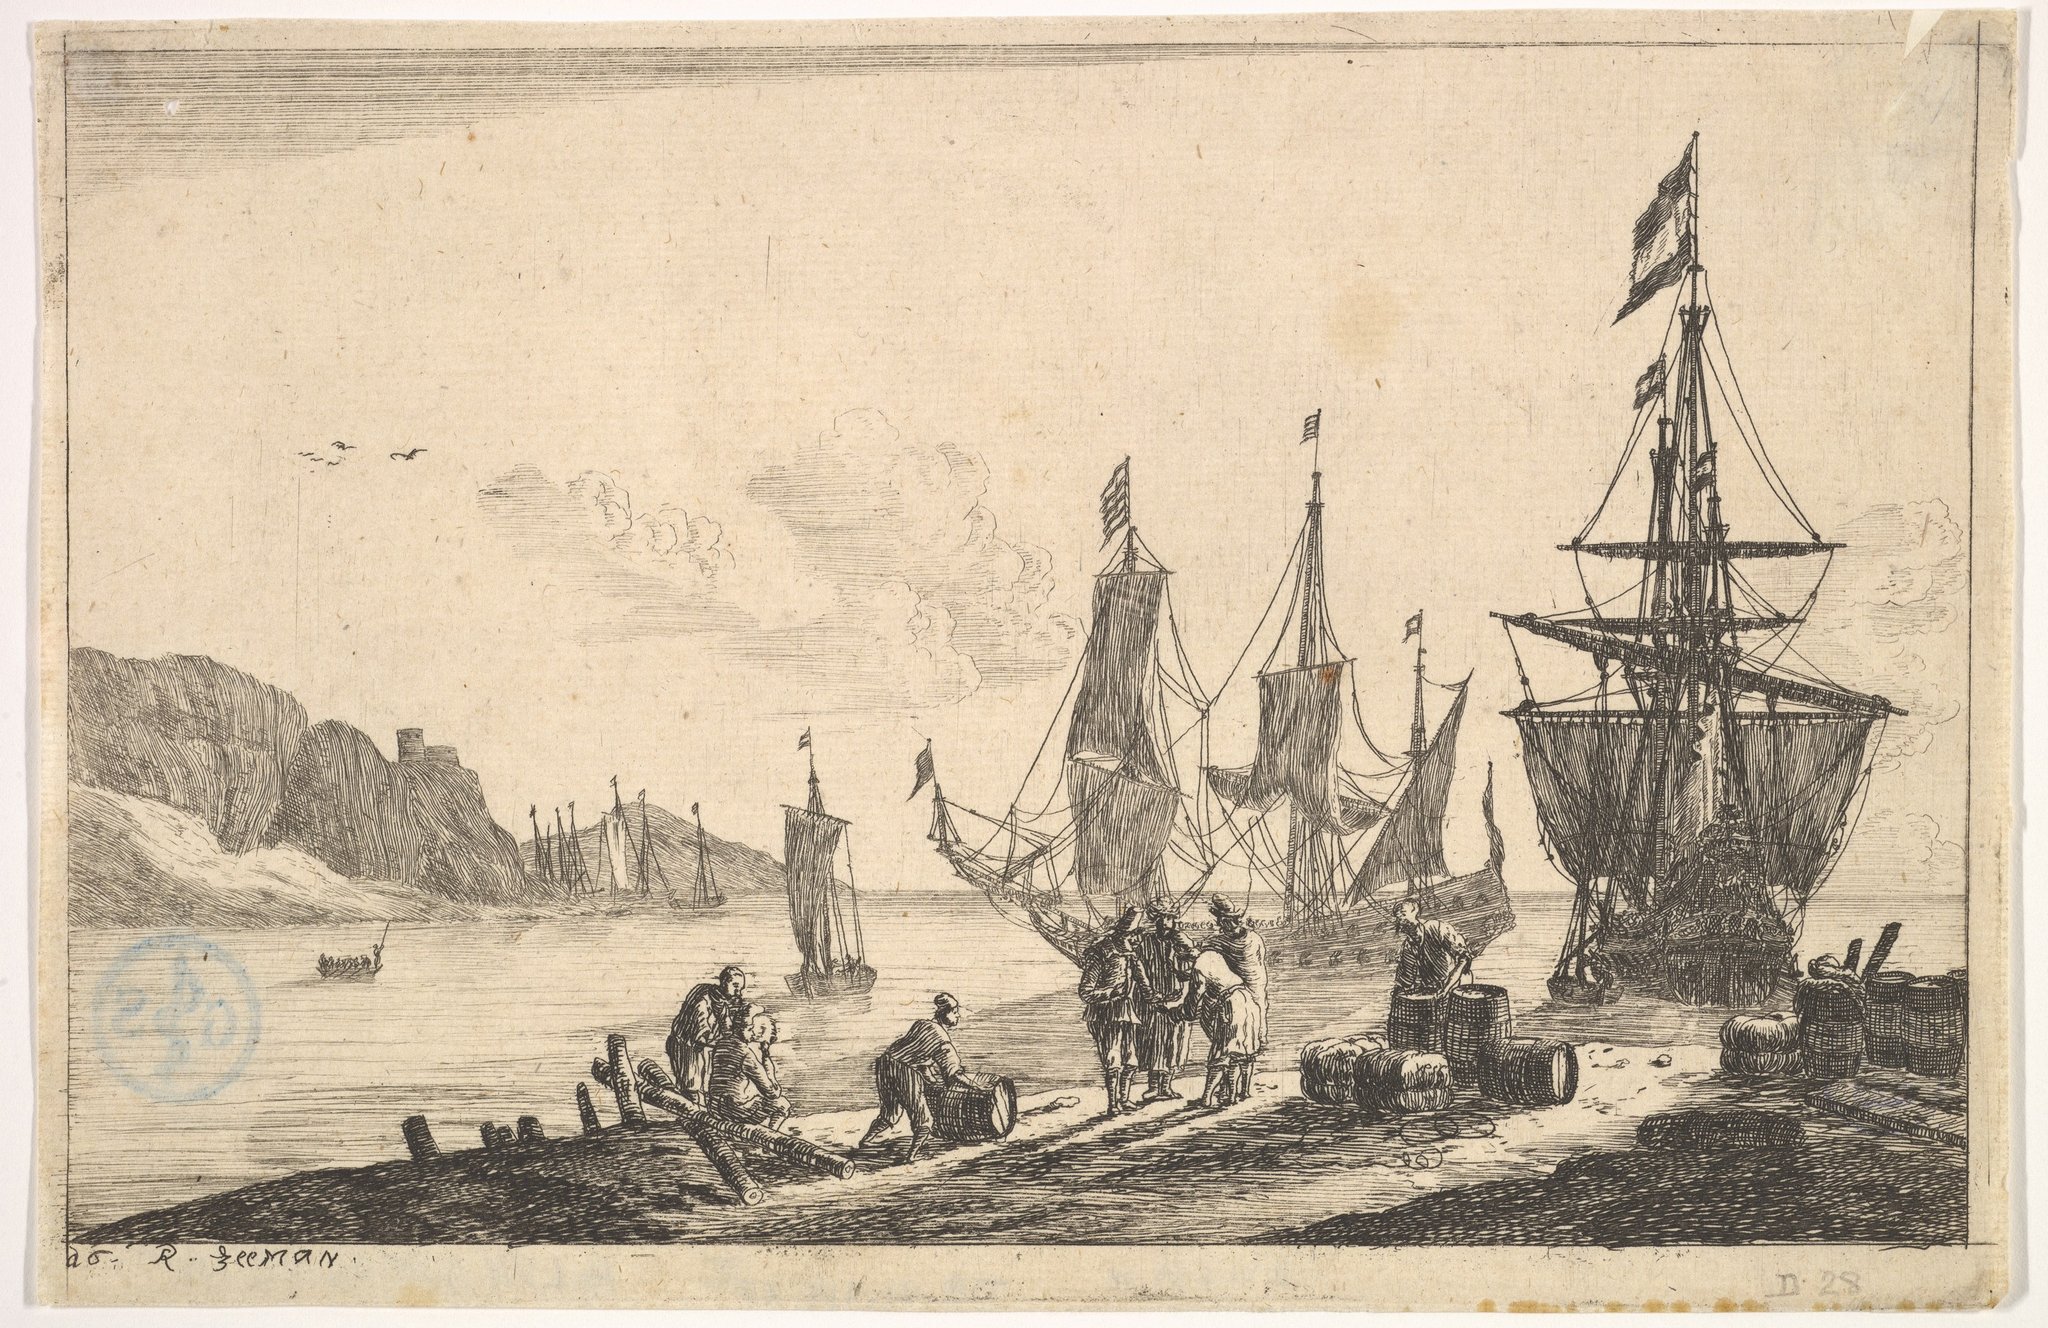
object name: print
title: Bay with Sailing Vessels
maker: reinier nooms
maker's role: artist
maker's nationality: dutch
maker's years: 1623-1664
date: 1601-1700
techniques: etching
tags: men,ships